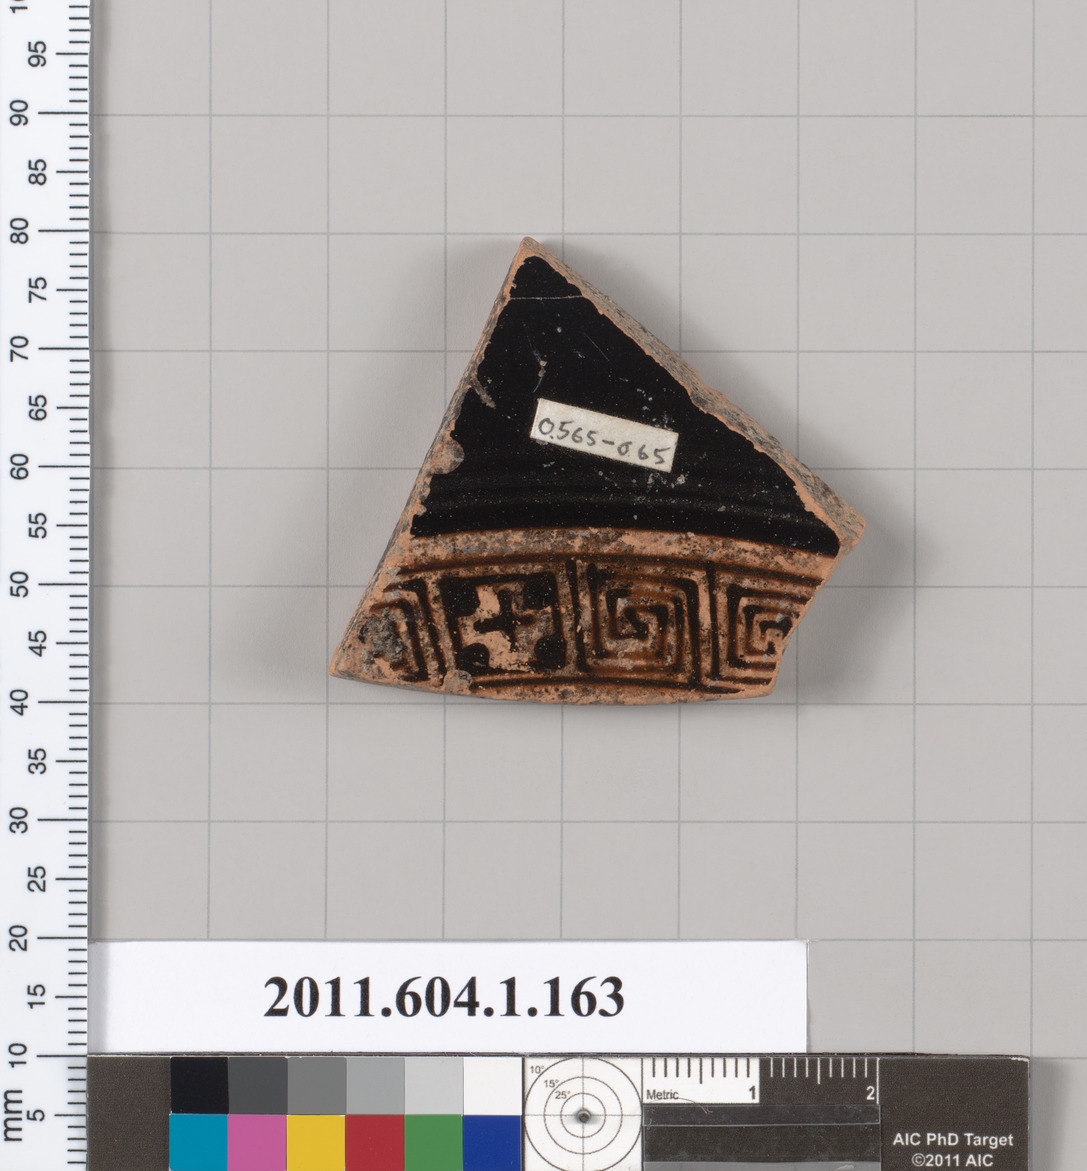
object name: kylix fragment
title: Terracotta fragment of a kylix (drinking cup)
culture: greek, attic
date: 470-450 BCE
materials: terracotta